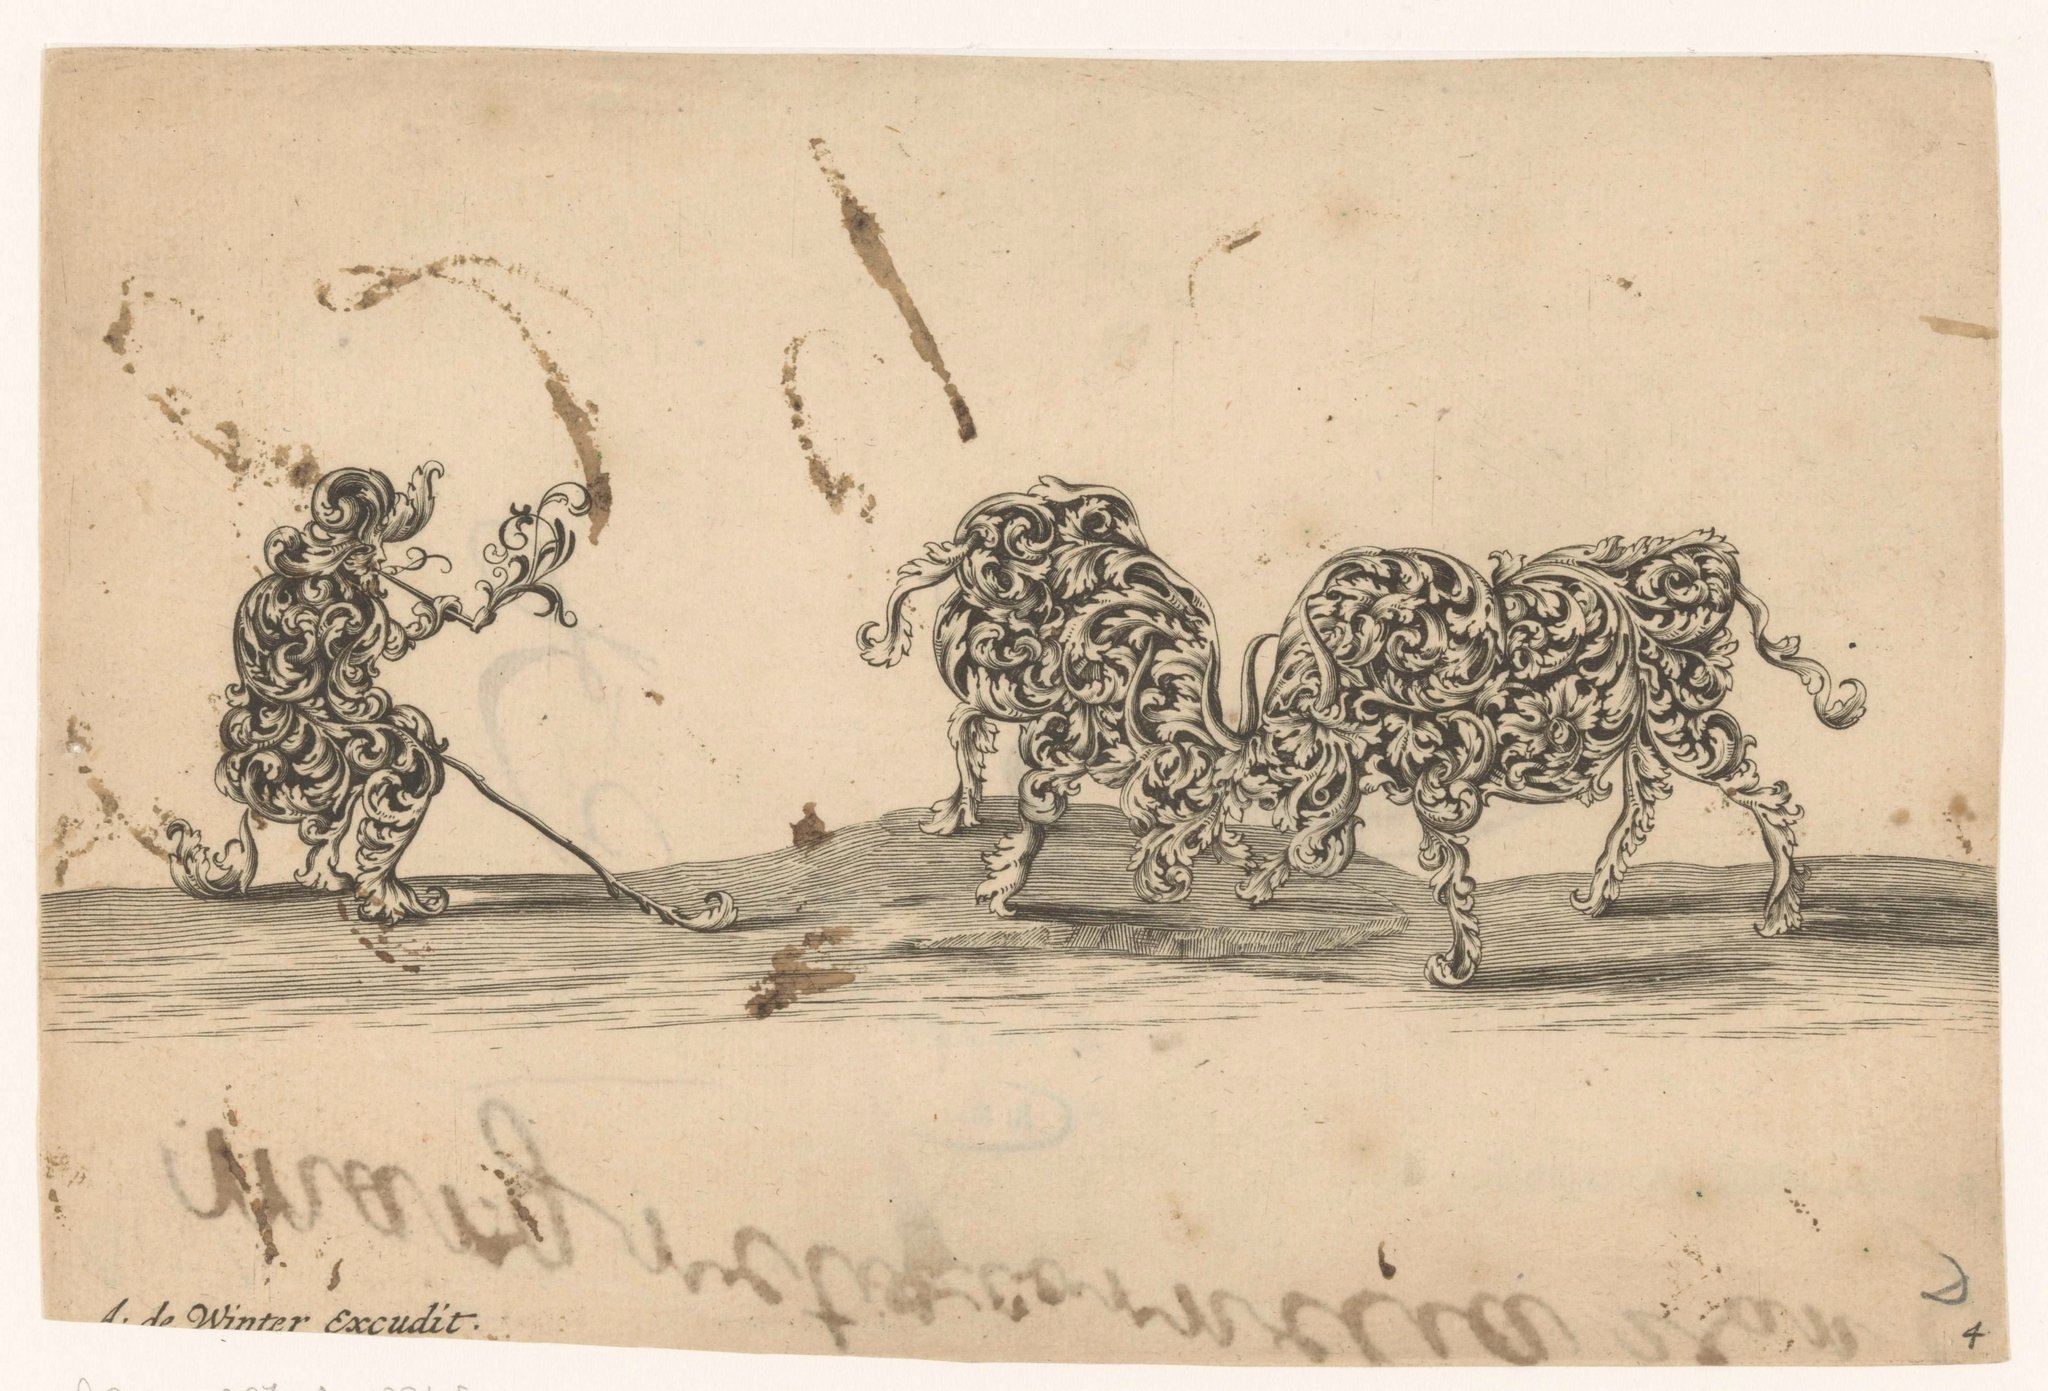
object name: ornament print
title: Twee vechtende geiten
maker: anthonie de winter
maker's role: print maker, publisher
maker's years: 1652-1707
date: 1698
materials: paper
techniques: engraving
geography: germany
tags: goat, foliage, tendrils, branches ~ ornament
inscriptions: collector's mark: Lugt 2228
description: Blad 4 uit serie van 6 (mogelijk 8) bladen met ontwerpen voor goudsmeden met figuren van bladranken. Het gaat om een serie met Nederlandse tegenzijdige kopieën naar de serie Neu ersonnene Gold=Schmieds Grillen.